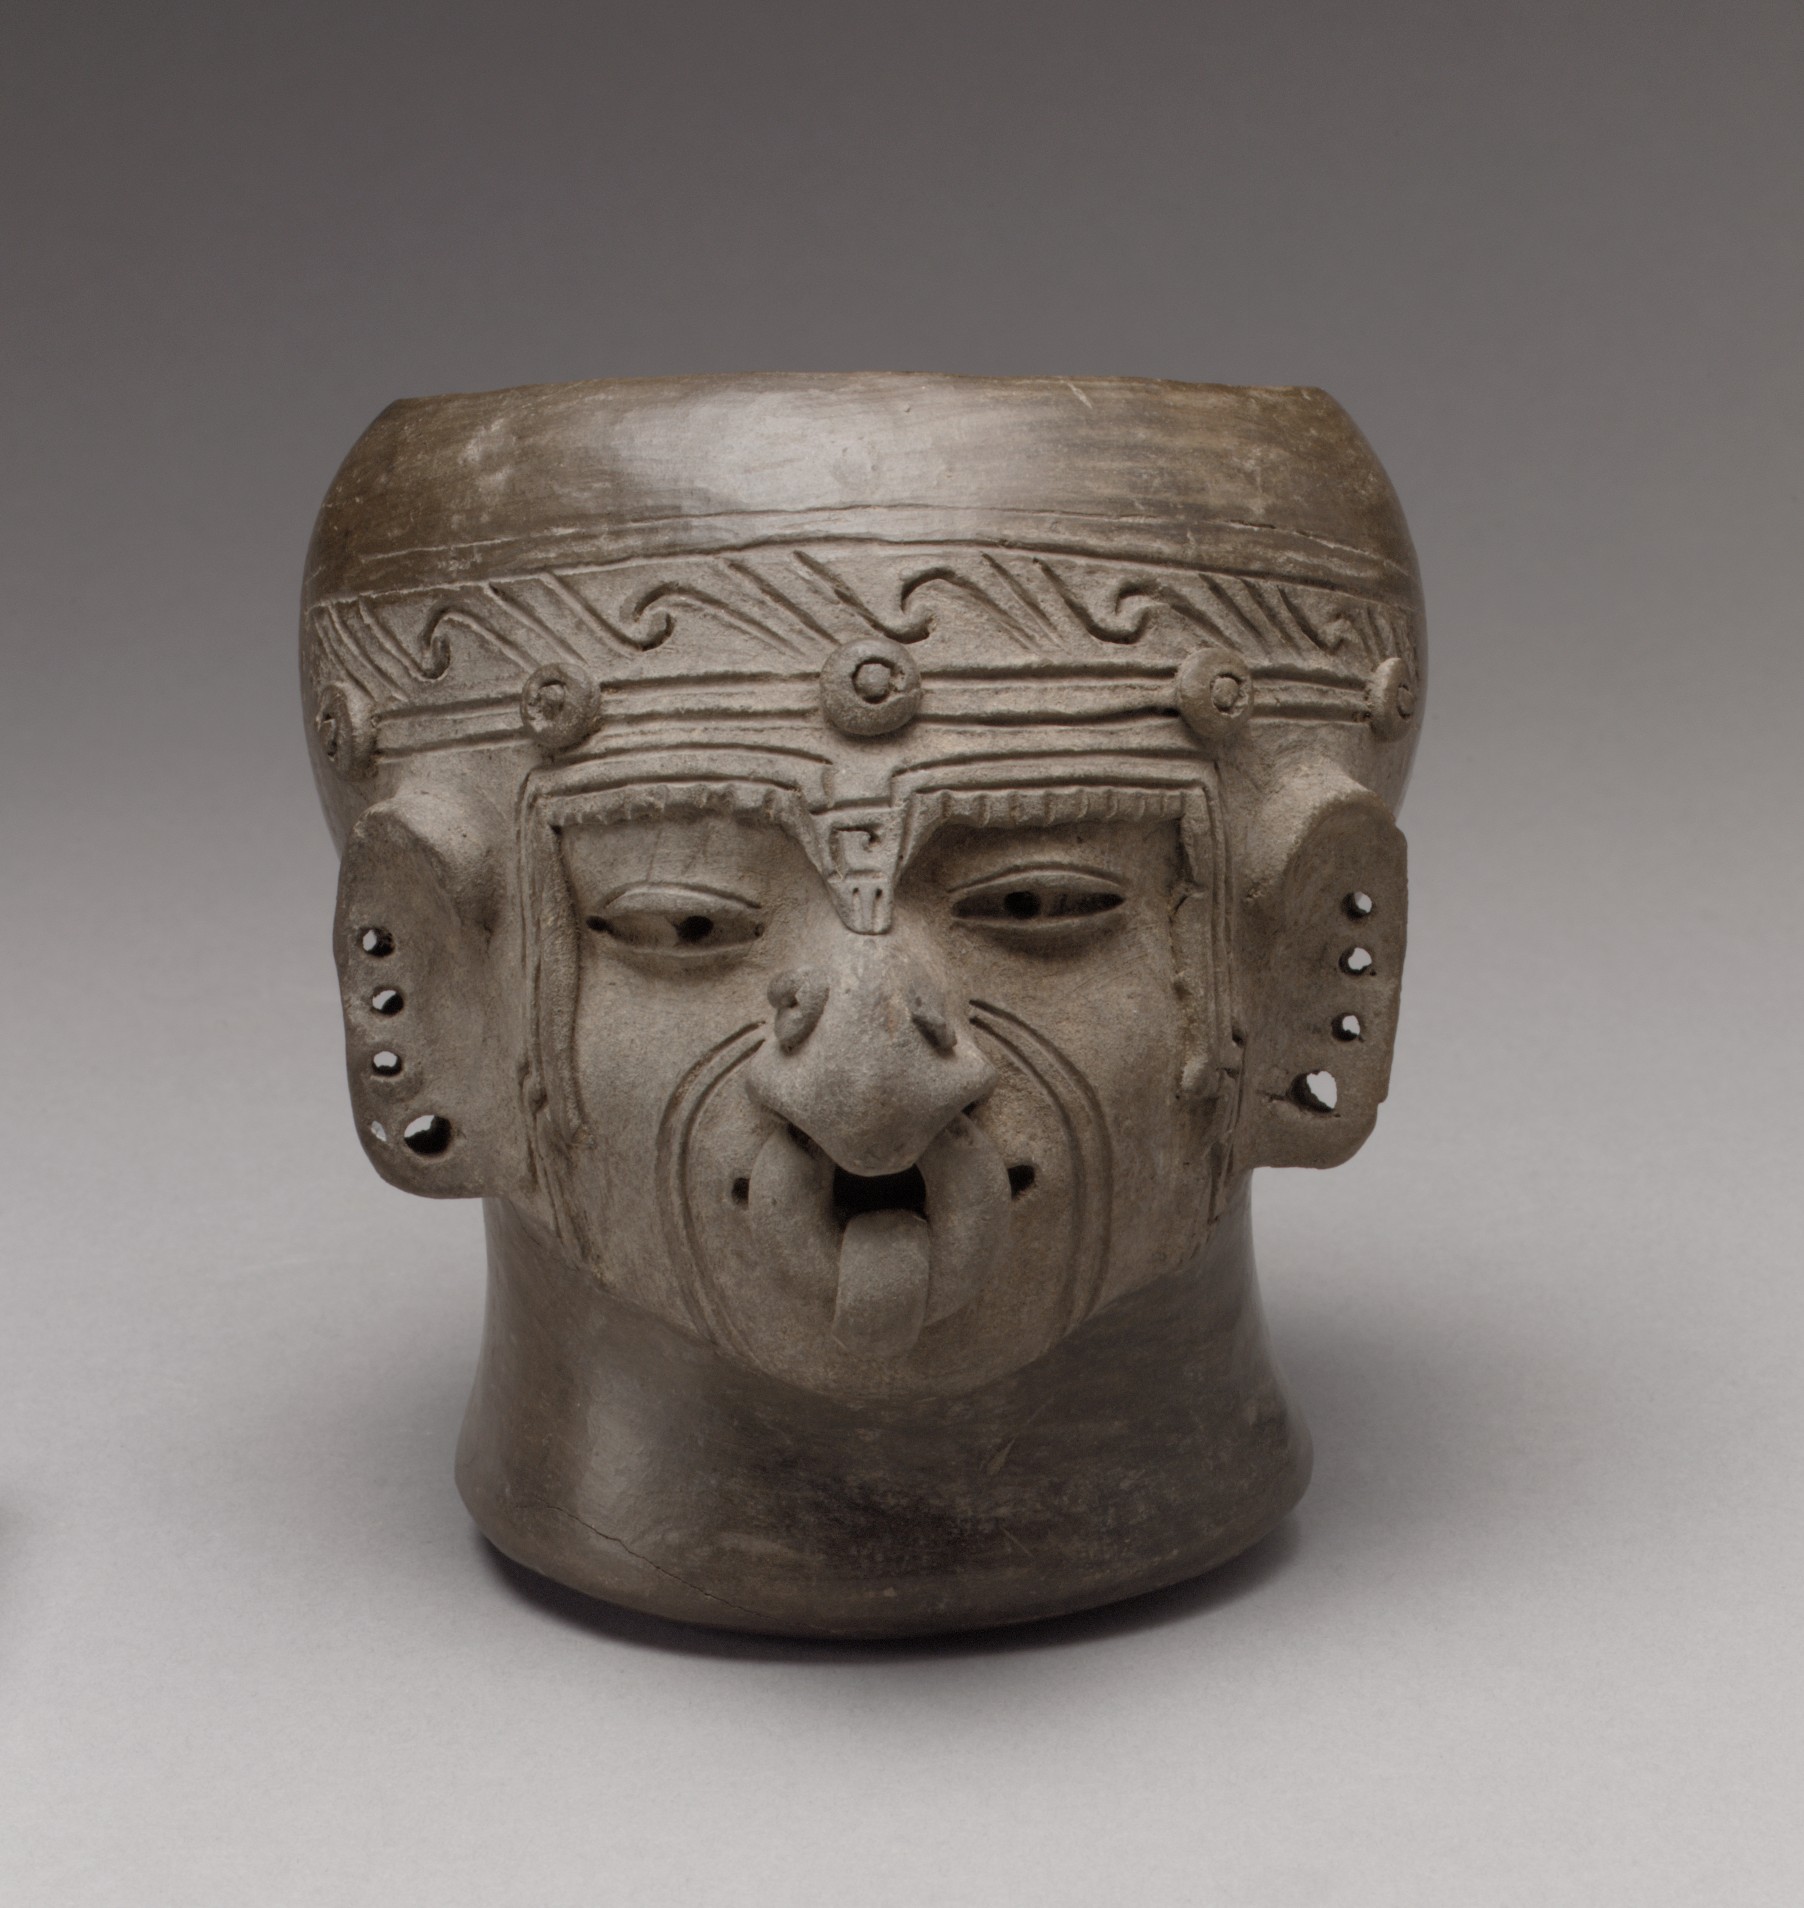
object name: vessel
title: Head-shaped vessel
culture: manteño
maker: manteño artist(s)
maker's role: artist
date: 701-1200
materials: ceramic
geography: ecuador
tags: heads